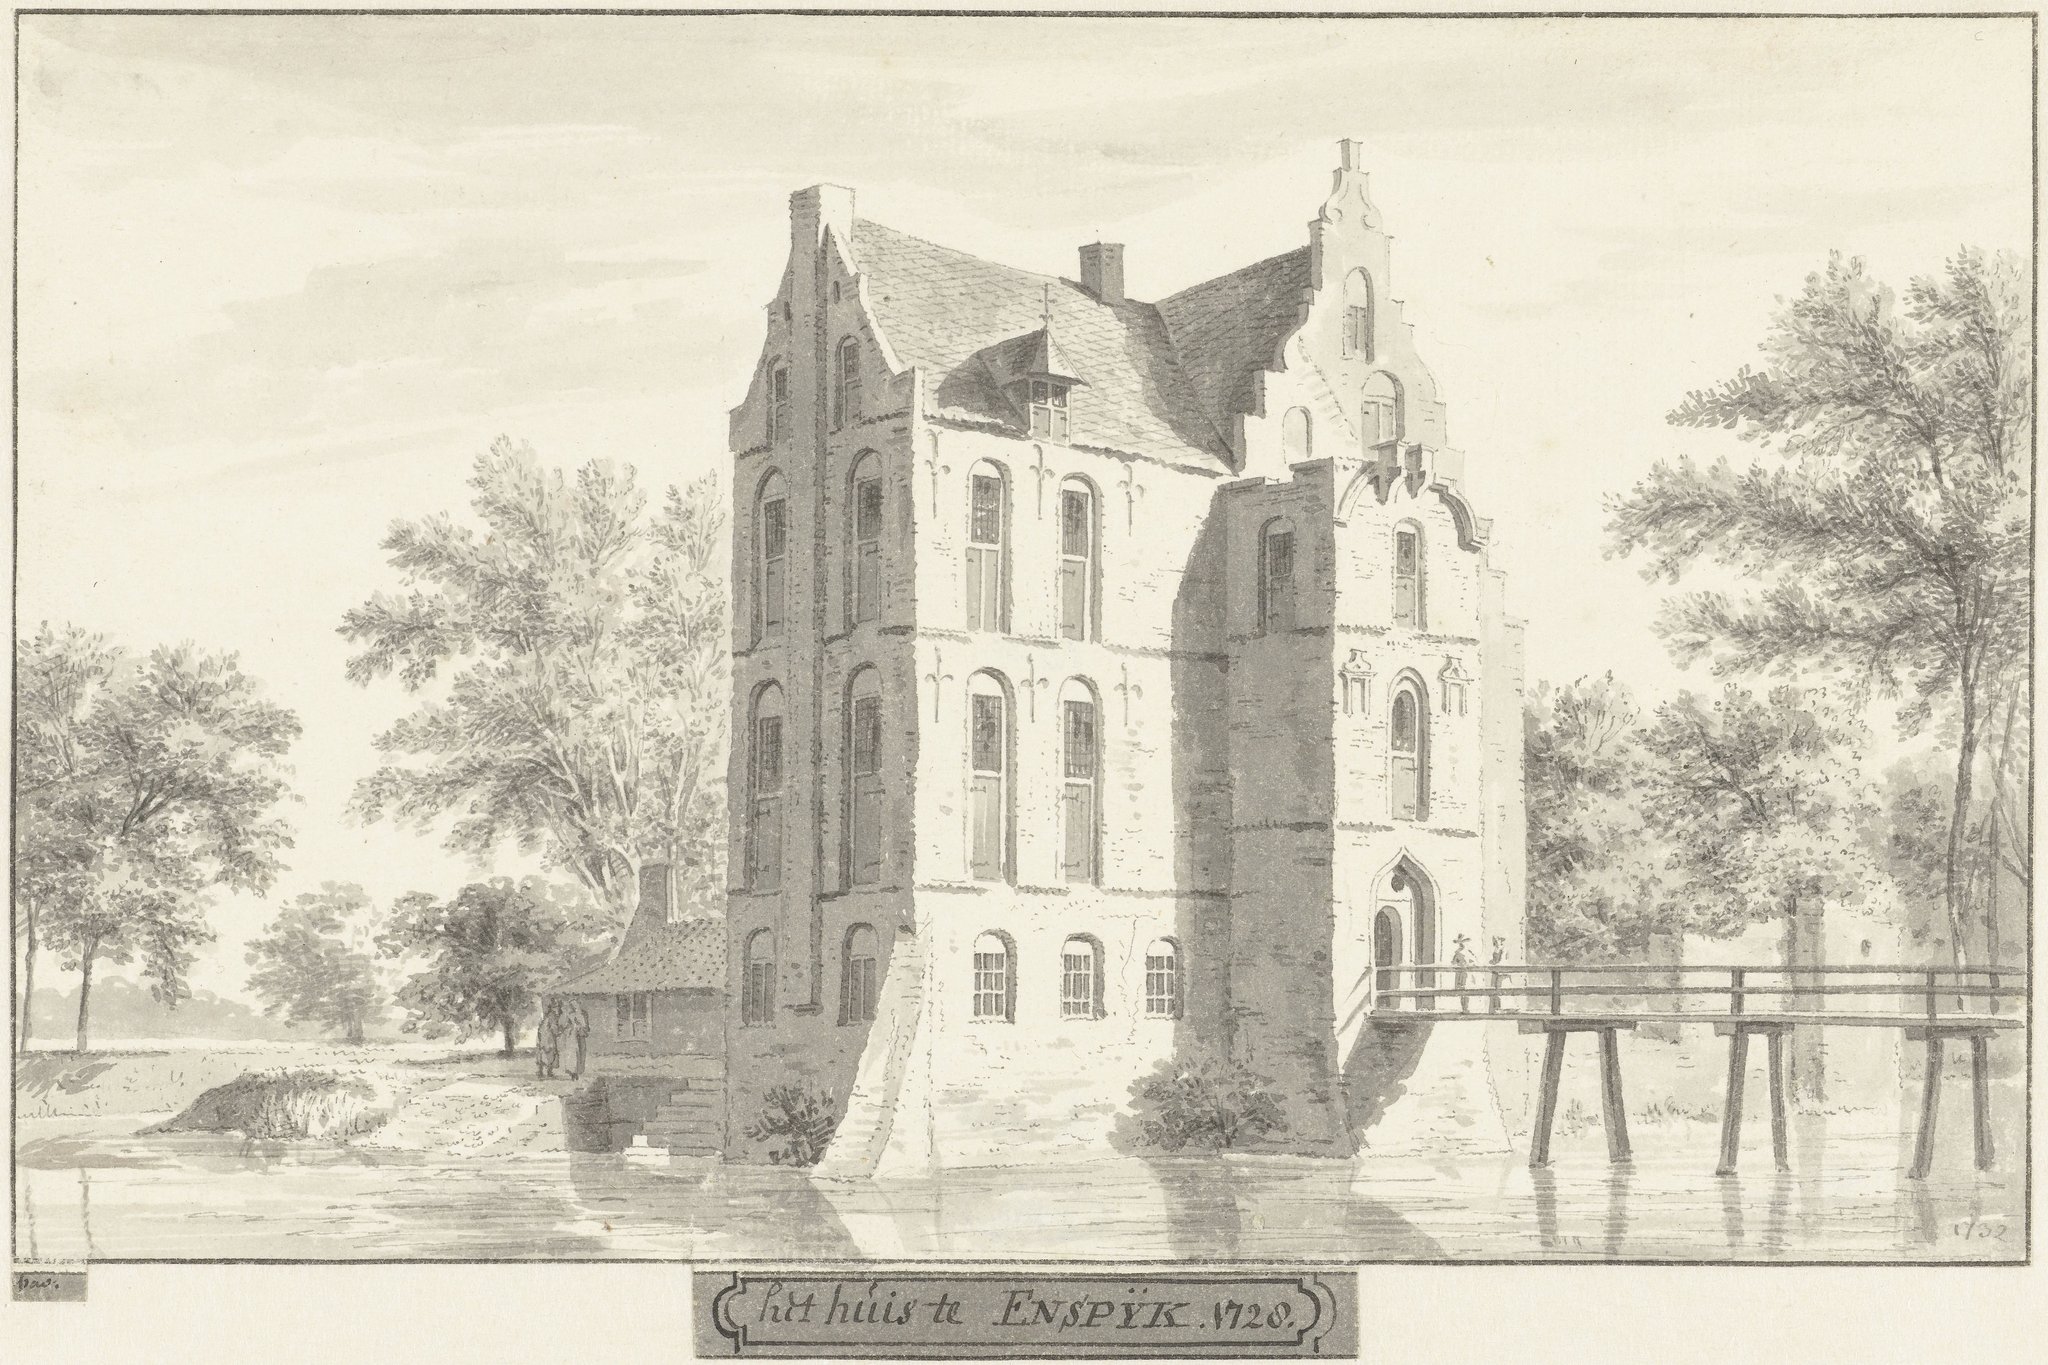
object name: drawing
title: Het kasteel te Enspijk, Gelderland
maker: cornelis pronk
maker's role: draughtsman, painter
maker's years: 1691-1759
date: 1728-1732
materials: ink, paper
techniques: brush, pen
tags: city-view, and landscape with man-made constructions, castle, rural housing, e.g. country-house, villa, cottage, gelderland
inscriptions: inscription: ‘1732 / hav Onder: het huis te ENSPIJK. 1728.’